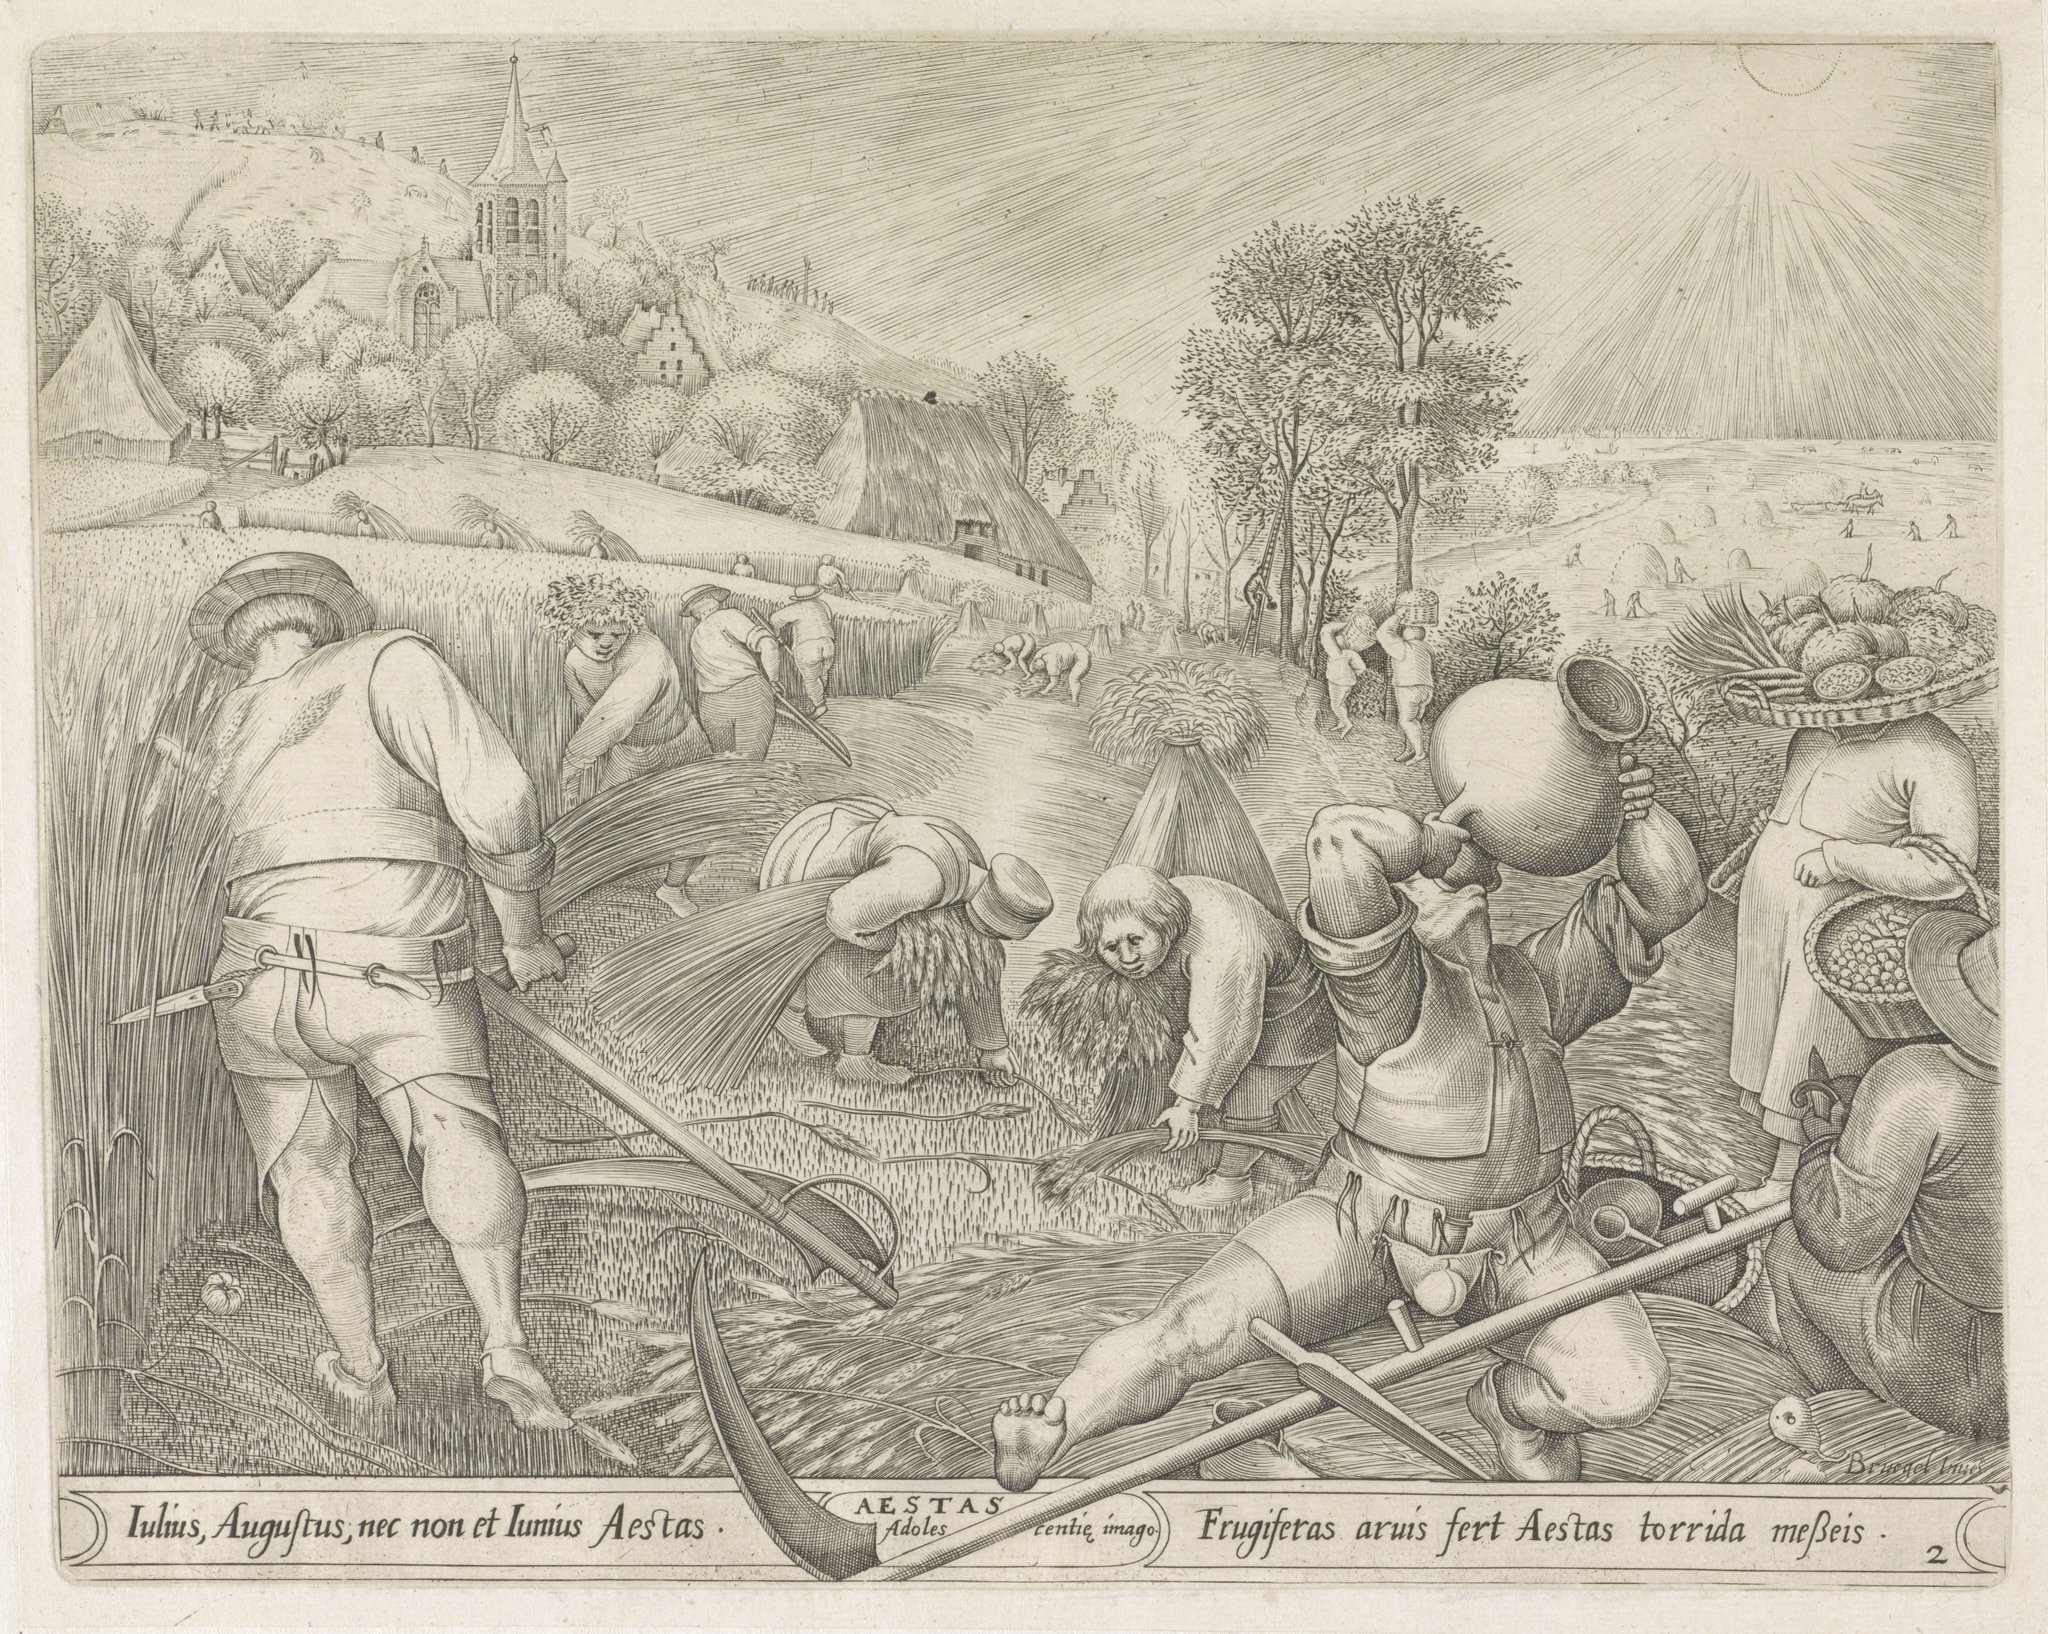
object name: print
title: Zomer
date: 1570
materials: paper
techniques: engraving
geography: amsterdam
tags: harvest, summer ~ human activities (the four seasons of the year), rest during harvest (eating, dancing, making love, etc.)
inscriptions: collector's mark: Lugt 2228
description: Het seizoen zomer: de maanden juni, juli en augustus. De bezigheden behorend bij de zomer: graanoogst, snijden van het graan met de zeis, rapen van aren en binden tot schoven. Rechts op de voorgrond het rusten, eten en drinken tijdens de oogst. Onder de voorstelling een tekst in het Latijn.